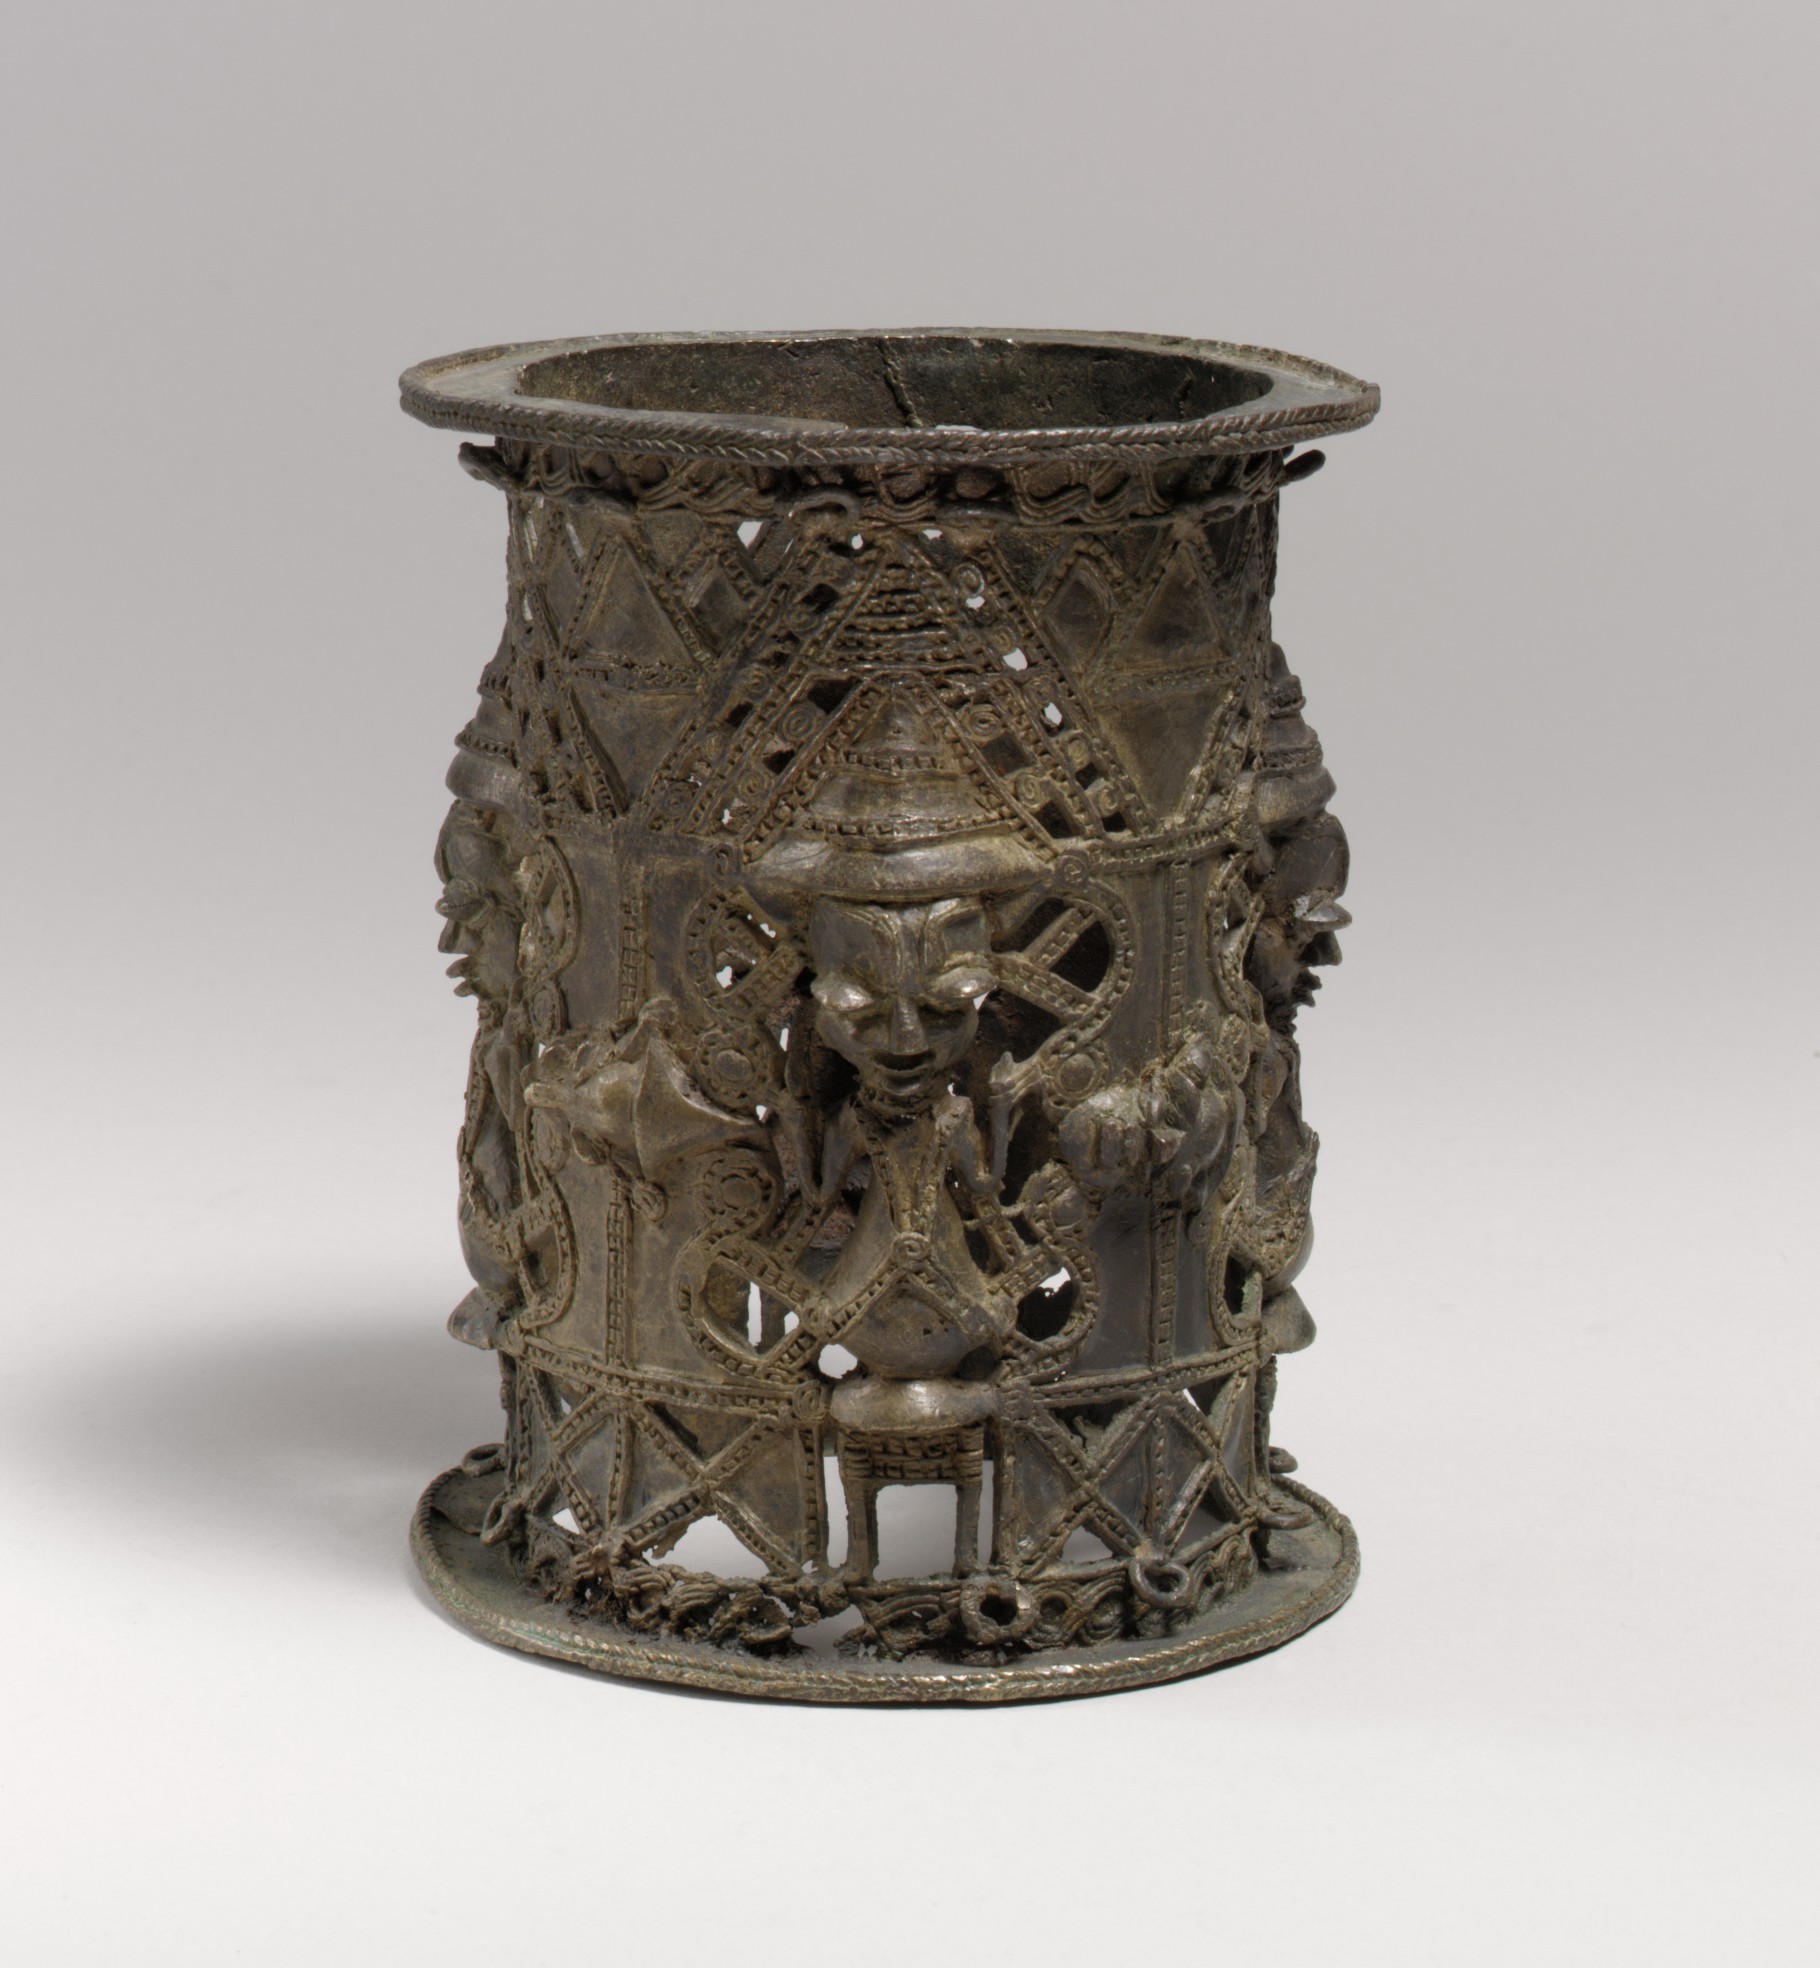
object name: bracelet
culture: yoruba peoples, ijebu group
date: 1401-1900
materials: brass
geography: nigeria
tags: human figures